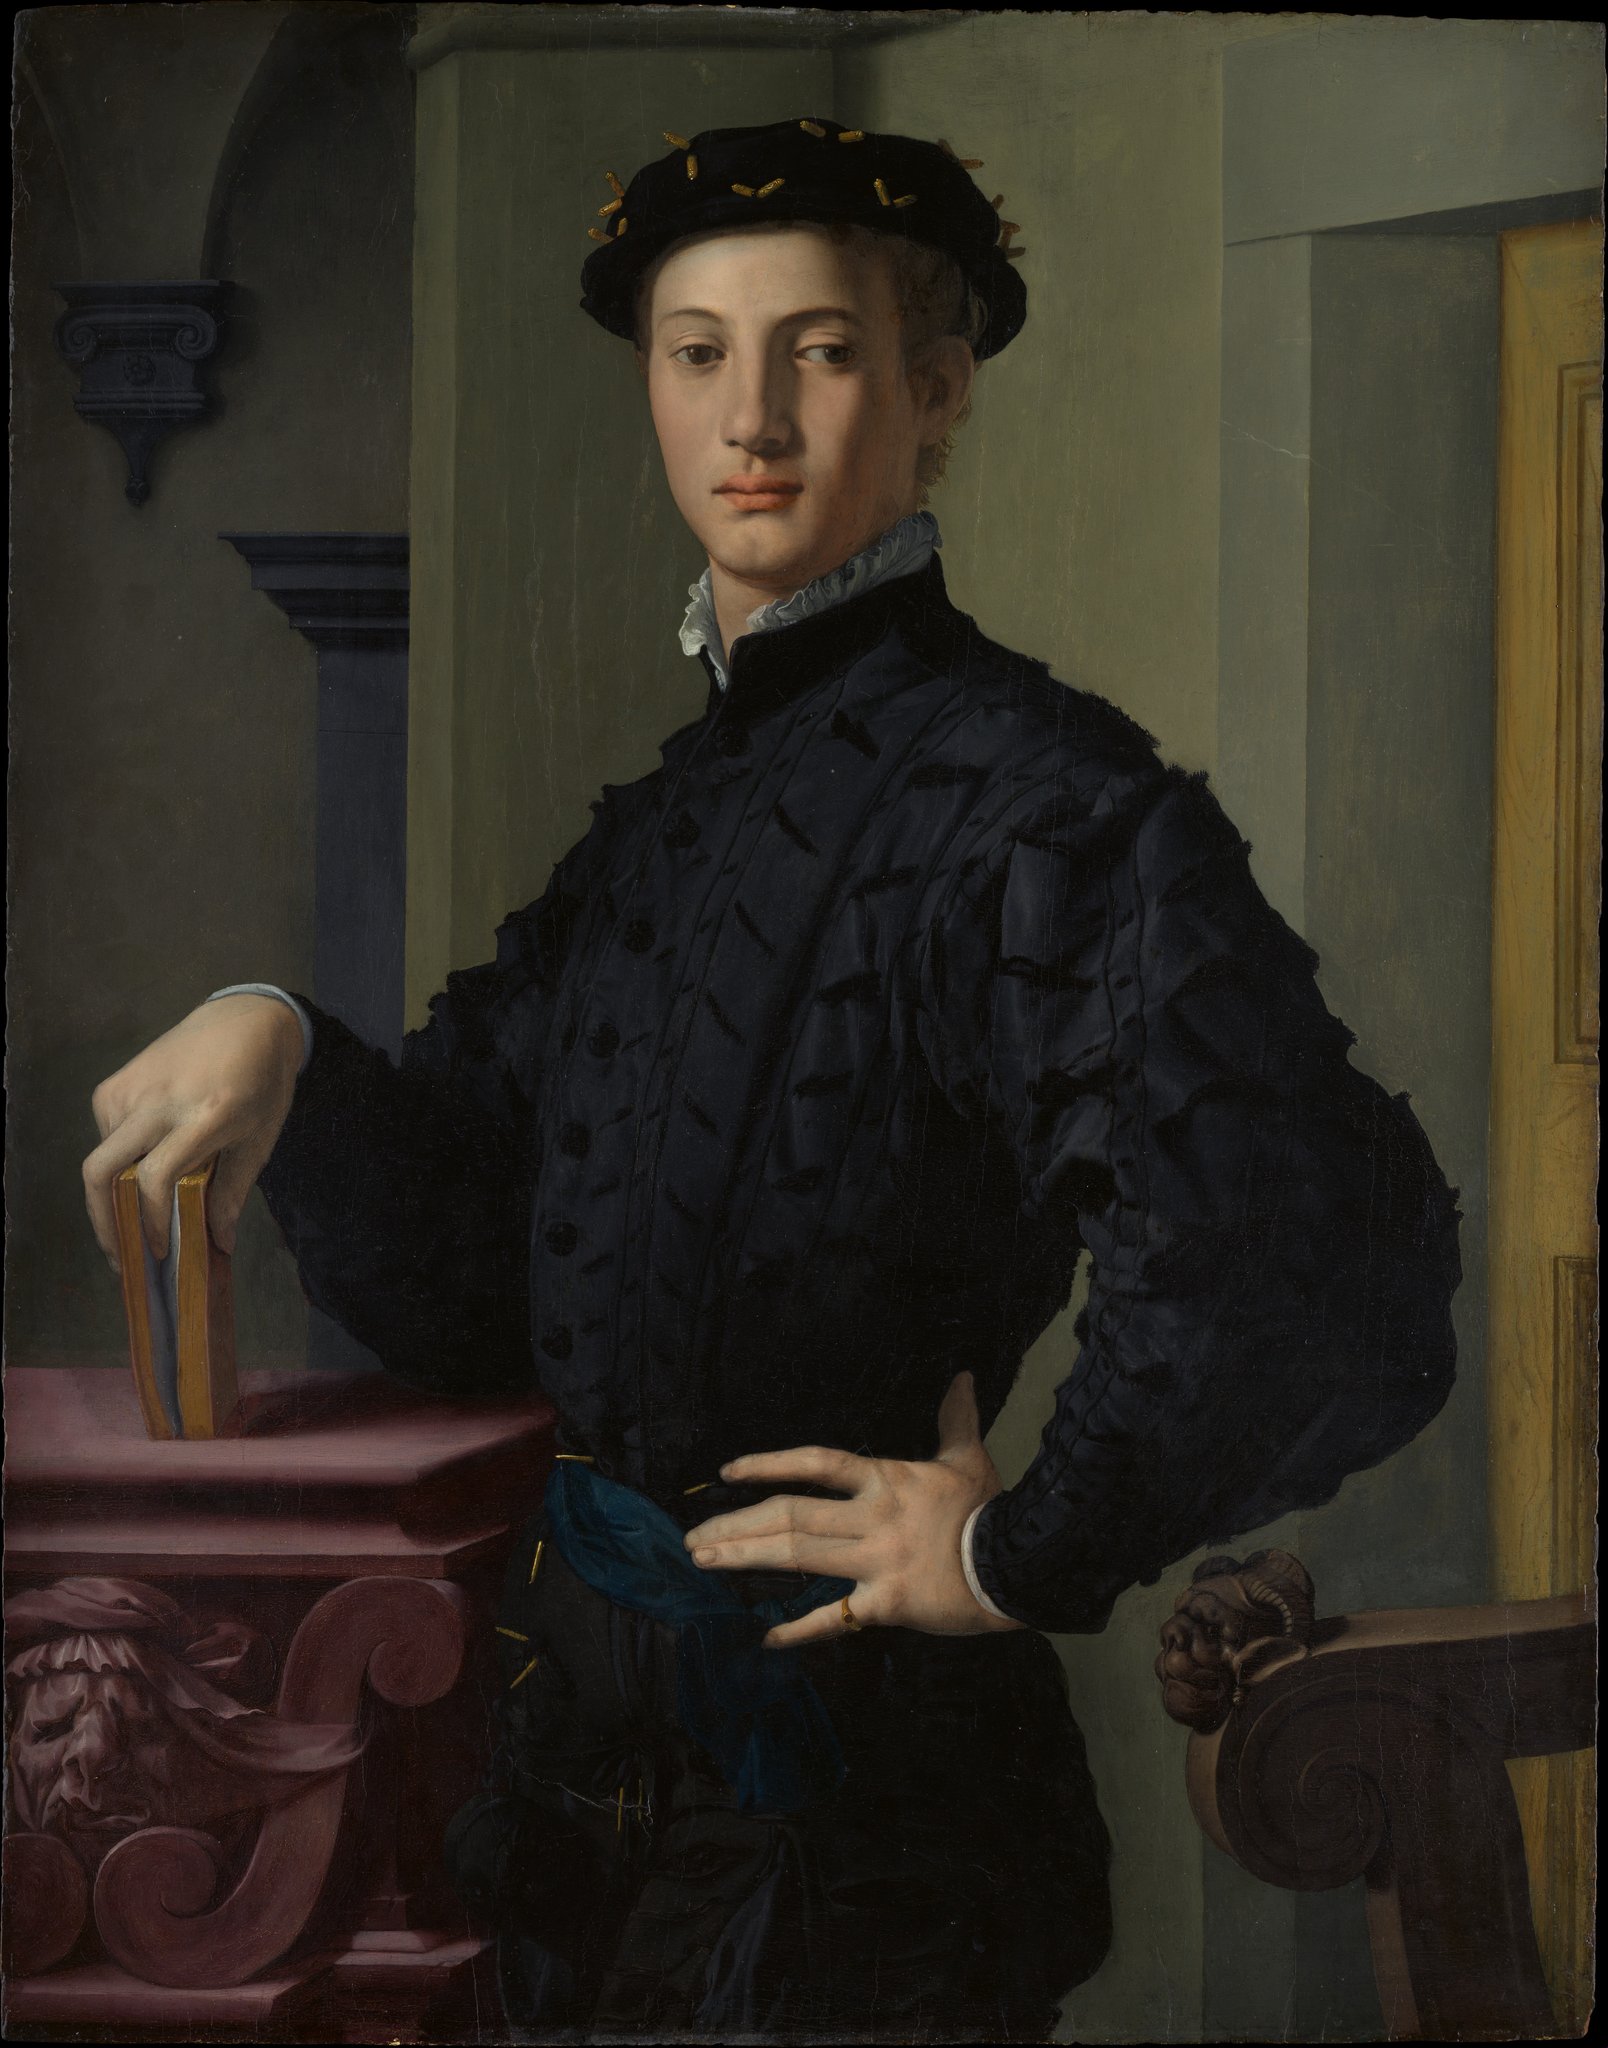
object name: painting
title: Portrait of a Young Man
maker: bronzino (agnolo di cosimo di mariano)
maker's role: artist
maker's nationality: italian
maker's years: 1503-1572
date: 1530-1539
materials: oil, wood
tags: men,portraits